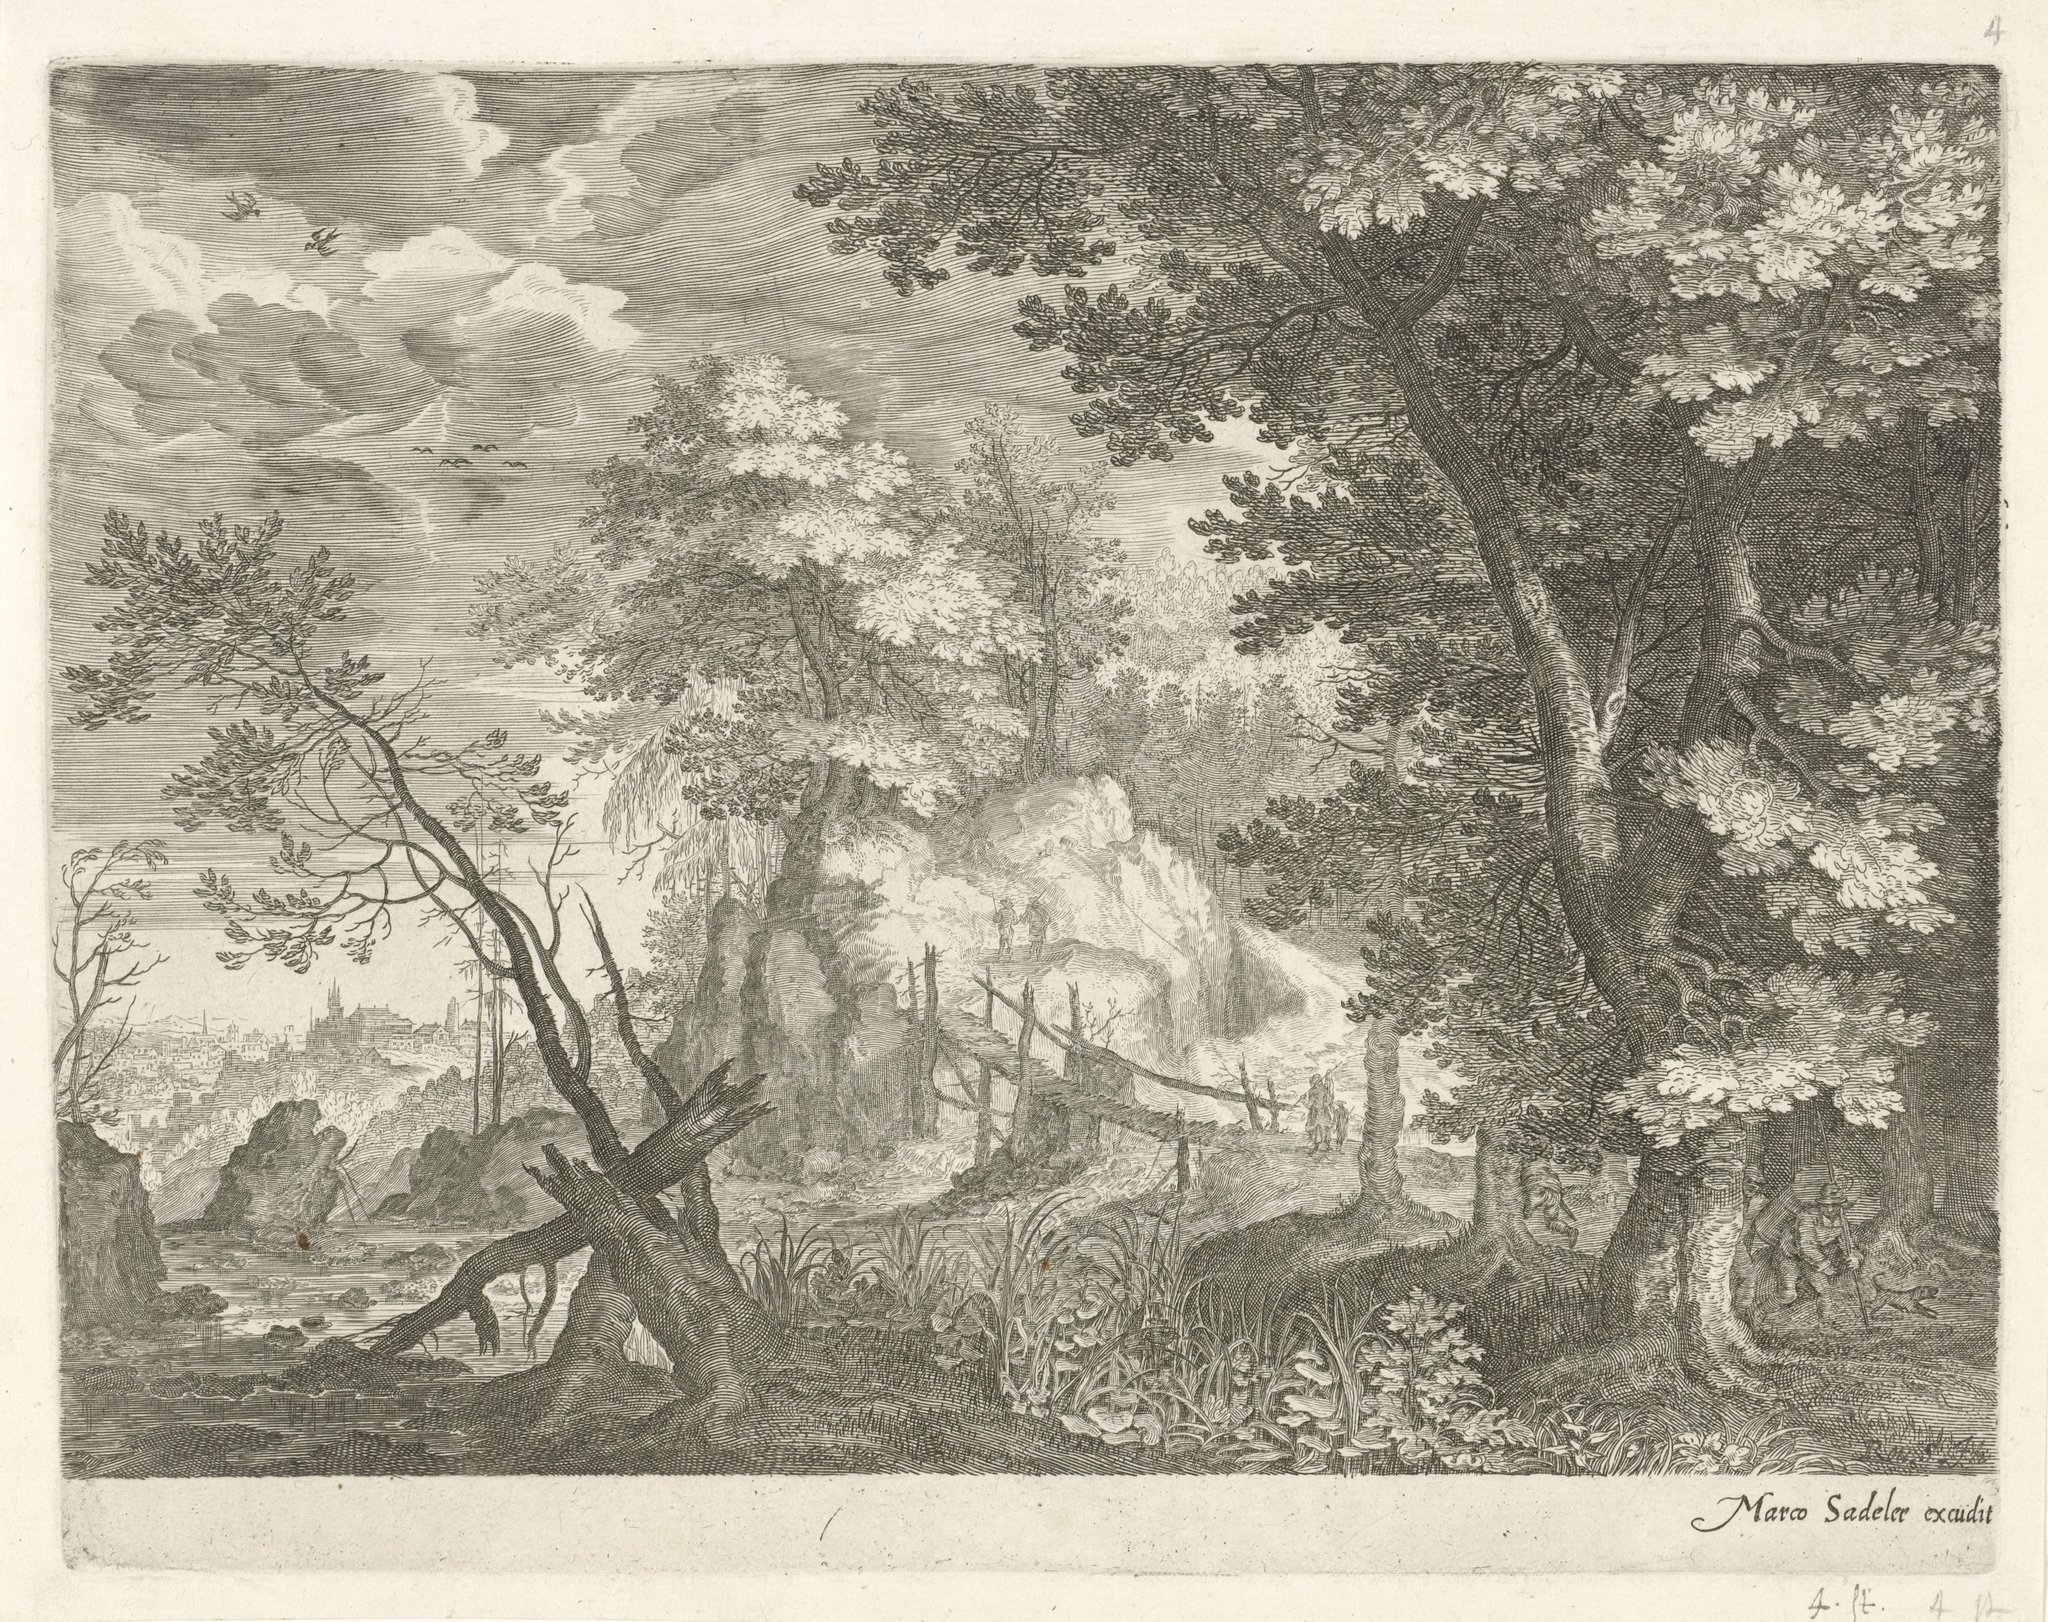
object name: print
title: Boslandschap met houten brug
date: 1609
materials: paper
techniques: engraving, etching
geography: venice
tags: forest, wood, landscape with bridge, viaduct or aqueduct (+ city(-scape) with figures, staffage)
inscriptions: collector's mark: Lugt 2228, inscription: ‘4Ft.’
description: Boslandschap met houten brug en enkele reizigers. Stad in de verte. Zesde prent van een zesdelige reeks met berglandschappen uit Tirol.